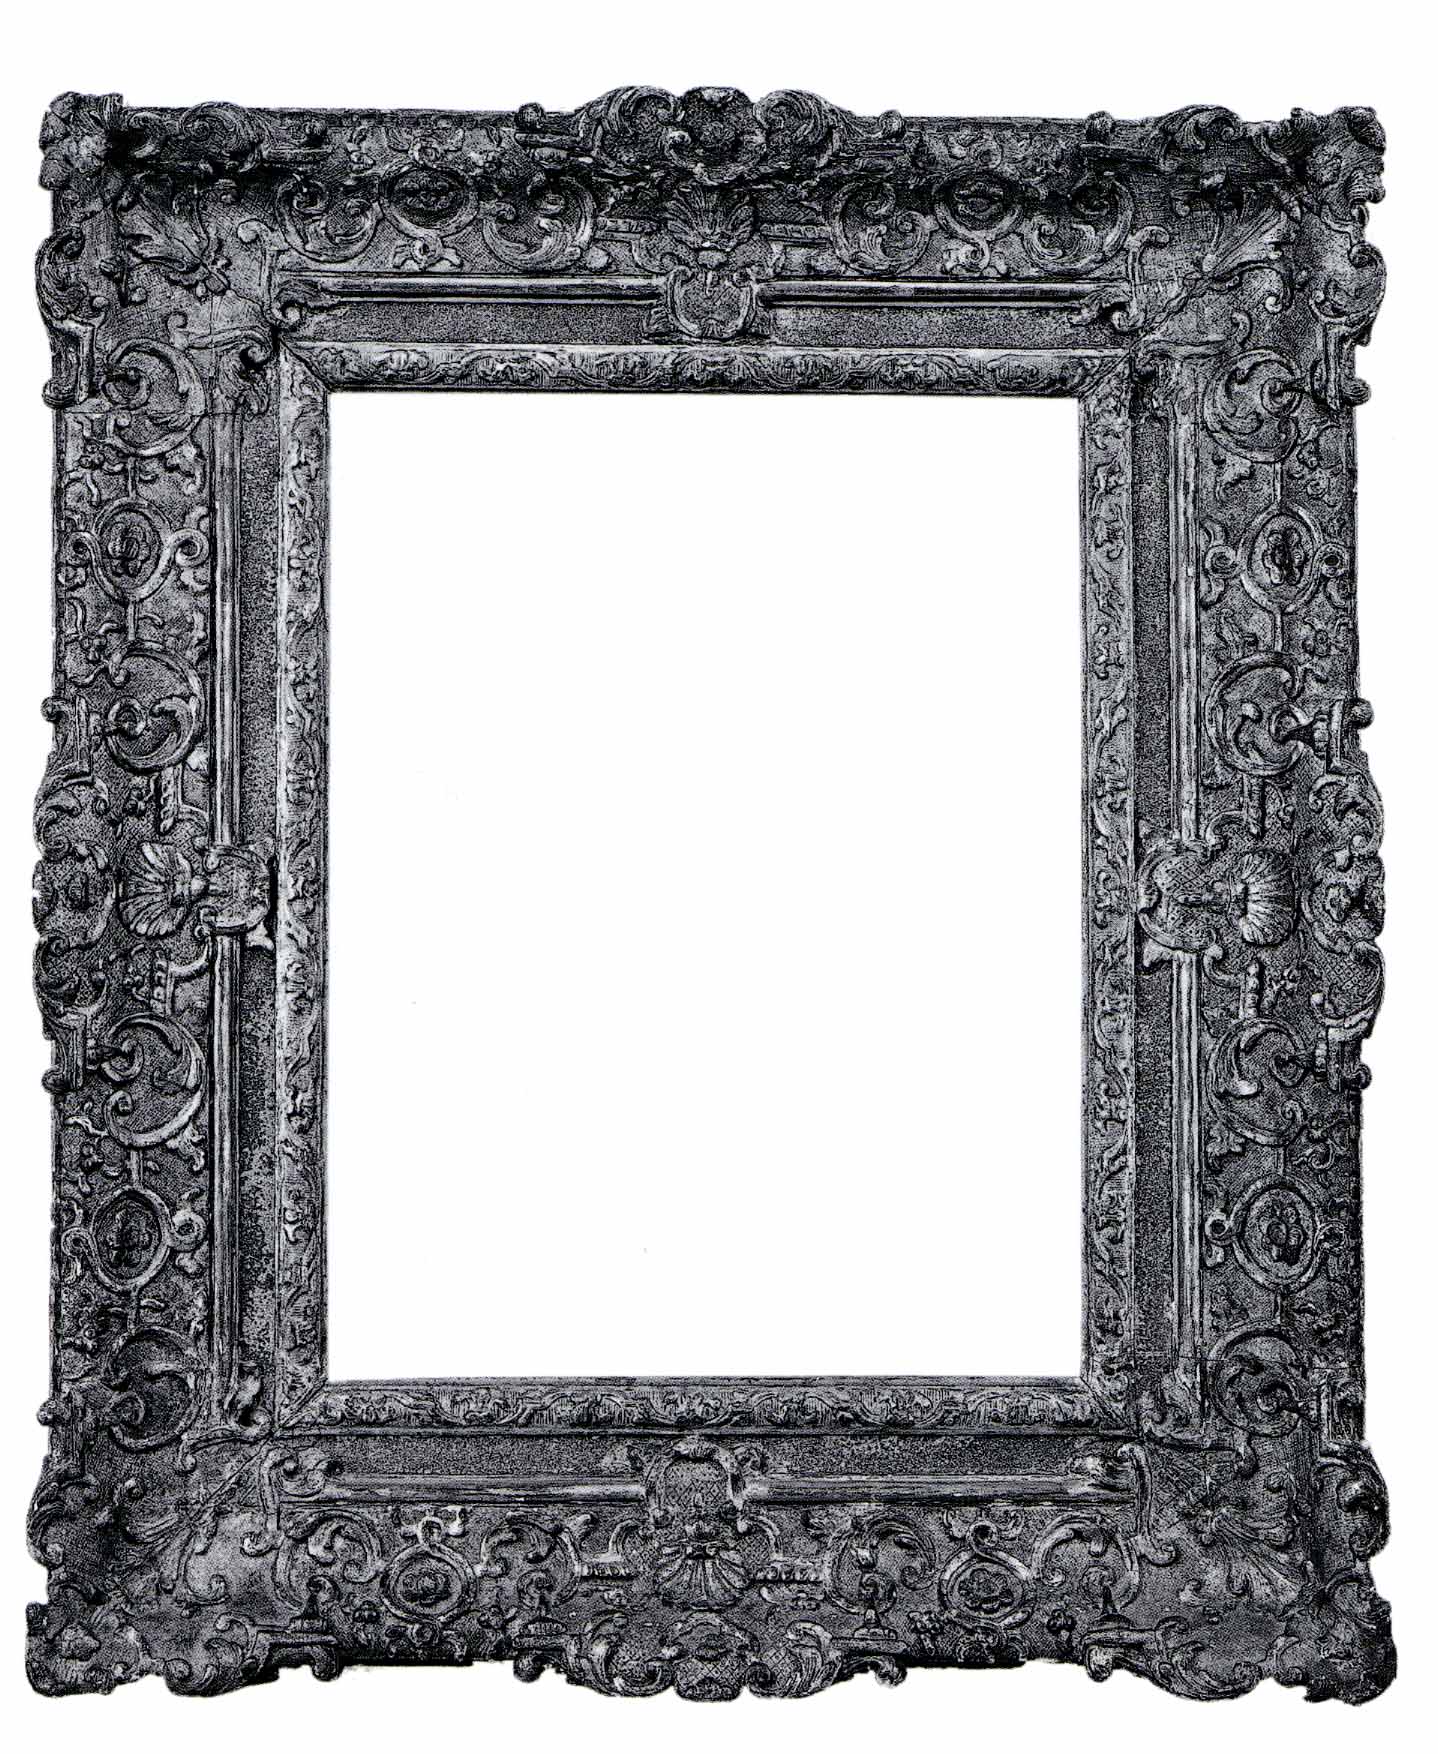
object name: frame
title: Ogee frame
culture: french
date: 1710-1720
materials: gilt, wood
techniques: carving